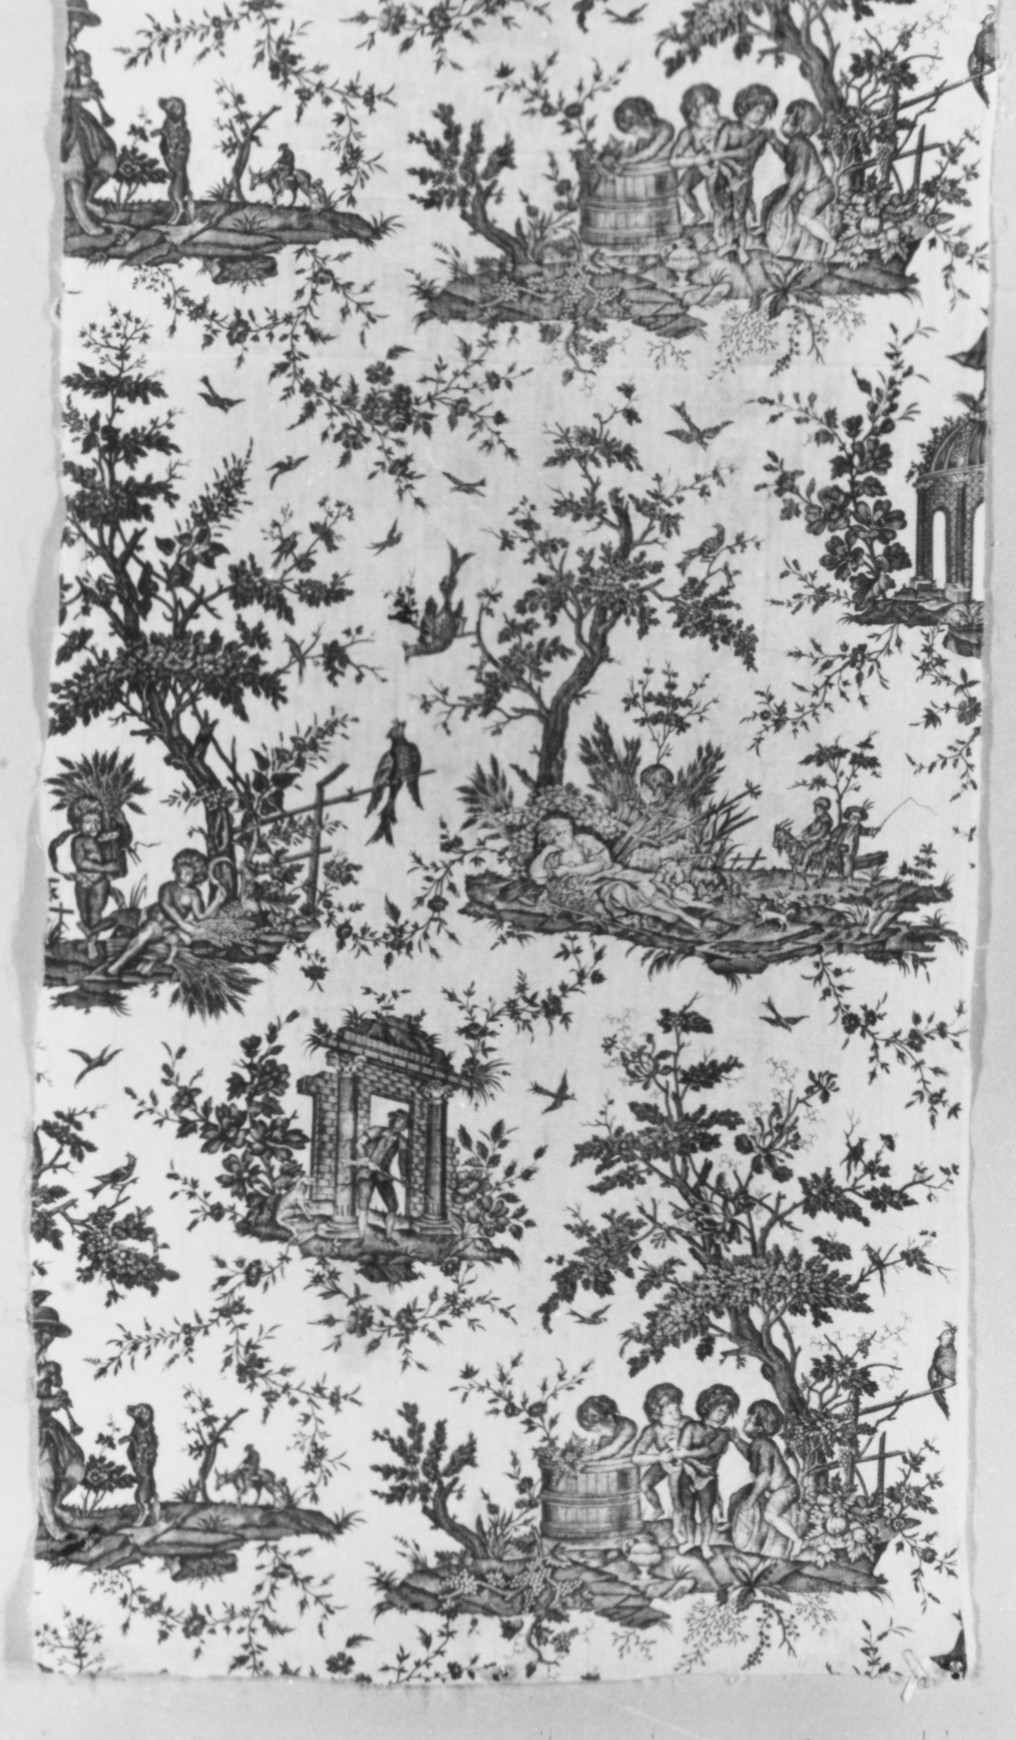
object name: piece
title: "Vintage Scenes"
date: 1701-1800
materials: cotton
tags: human figures,birds,trees